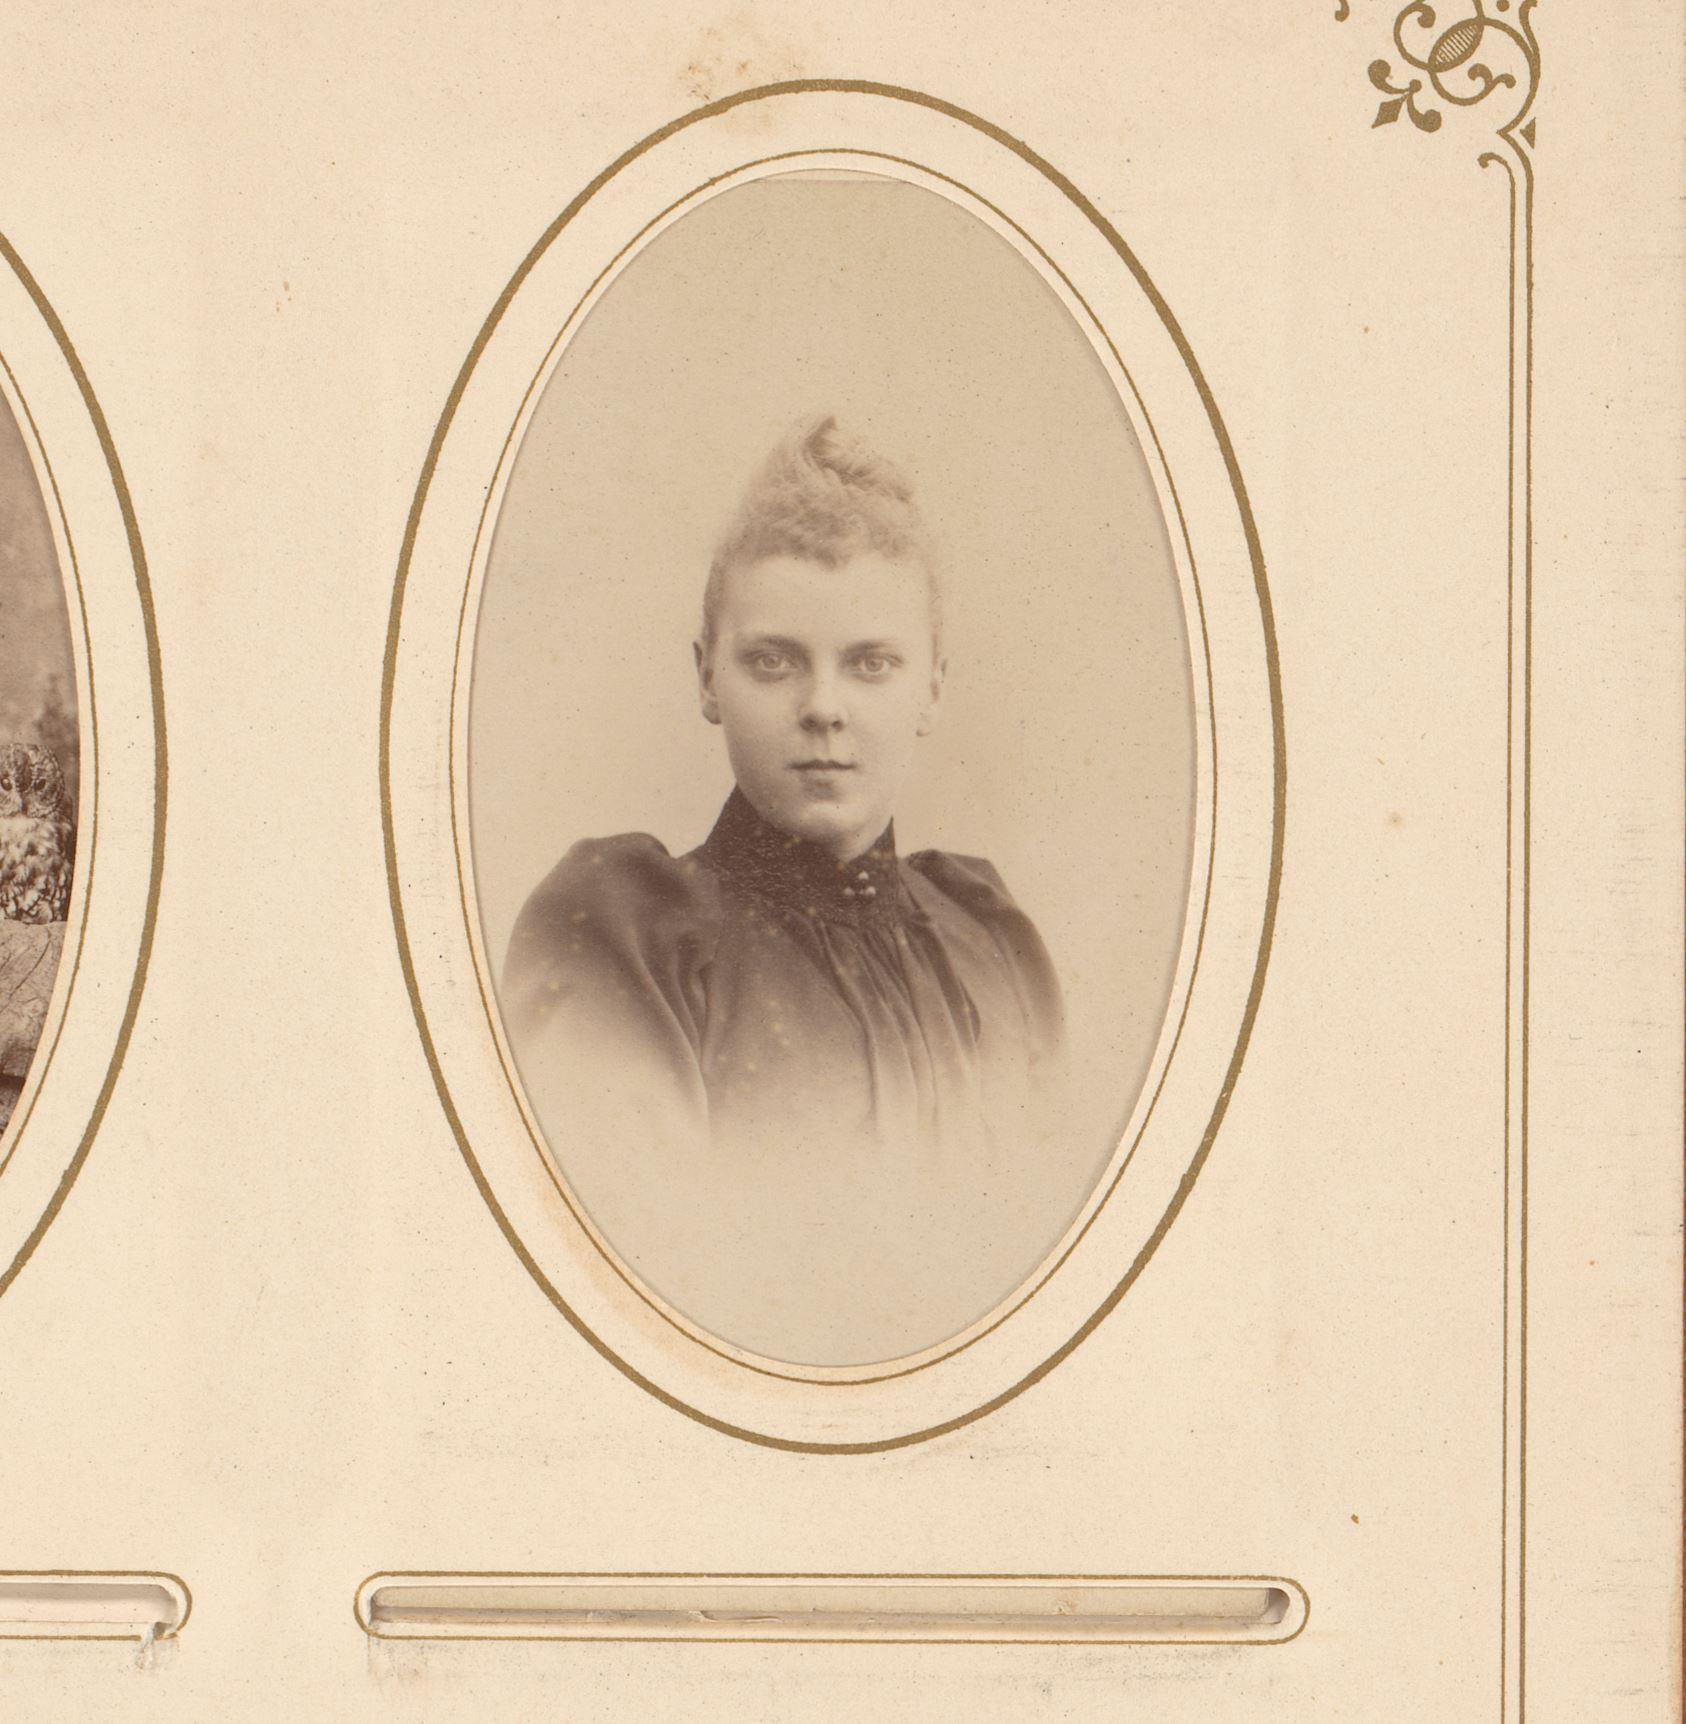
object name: photograph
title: Portret van een jonge vrouw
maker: hermann kapps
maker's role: fotograaf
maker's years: 1864-1922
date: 1874-1900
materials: cardboard, photographic support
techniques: albumen print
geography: hildesheim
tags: adolescent, young woman, maiden, historical persons - bb - woman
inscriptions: inscription: ‘Hermann Kapps/ Atelier für Photographie/ Hildesheim/ Bernward-Strasse 5,/ gegenüber der Hildesheimer Bank./ Die Platte bleibt für Nachbestellungen aufbewahrt./ Nach umstehendem sowie jedem andern Bilde fertige Copien vom/ kleinsten Format bis über Lebensgrösse.’, annotation: ‘Mutter, 18 jä[h]rig’